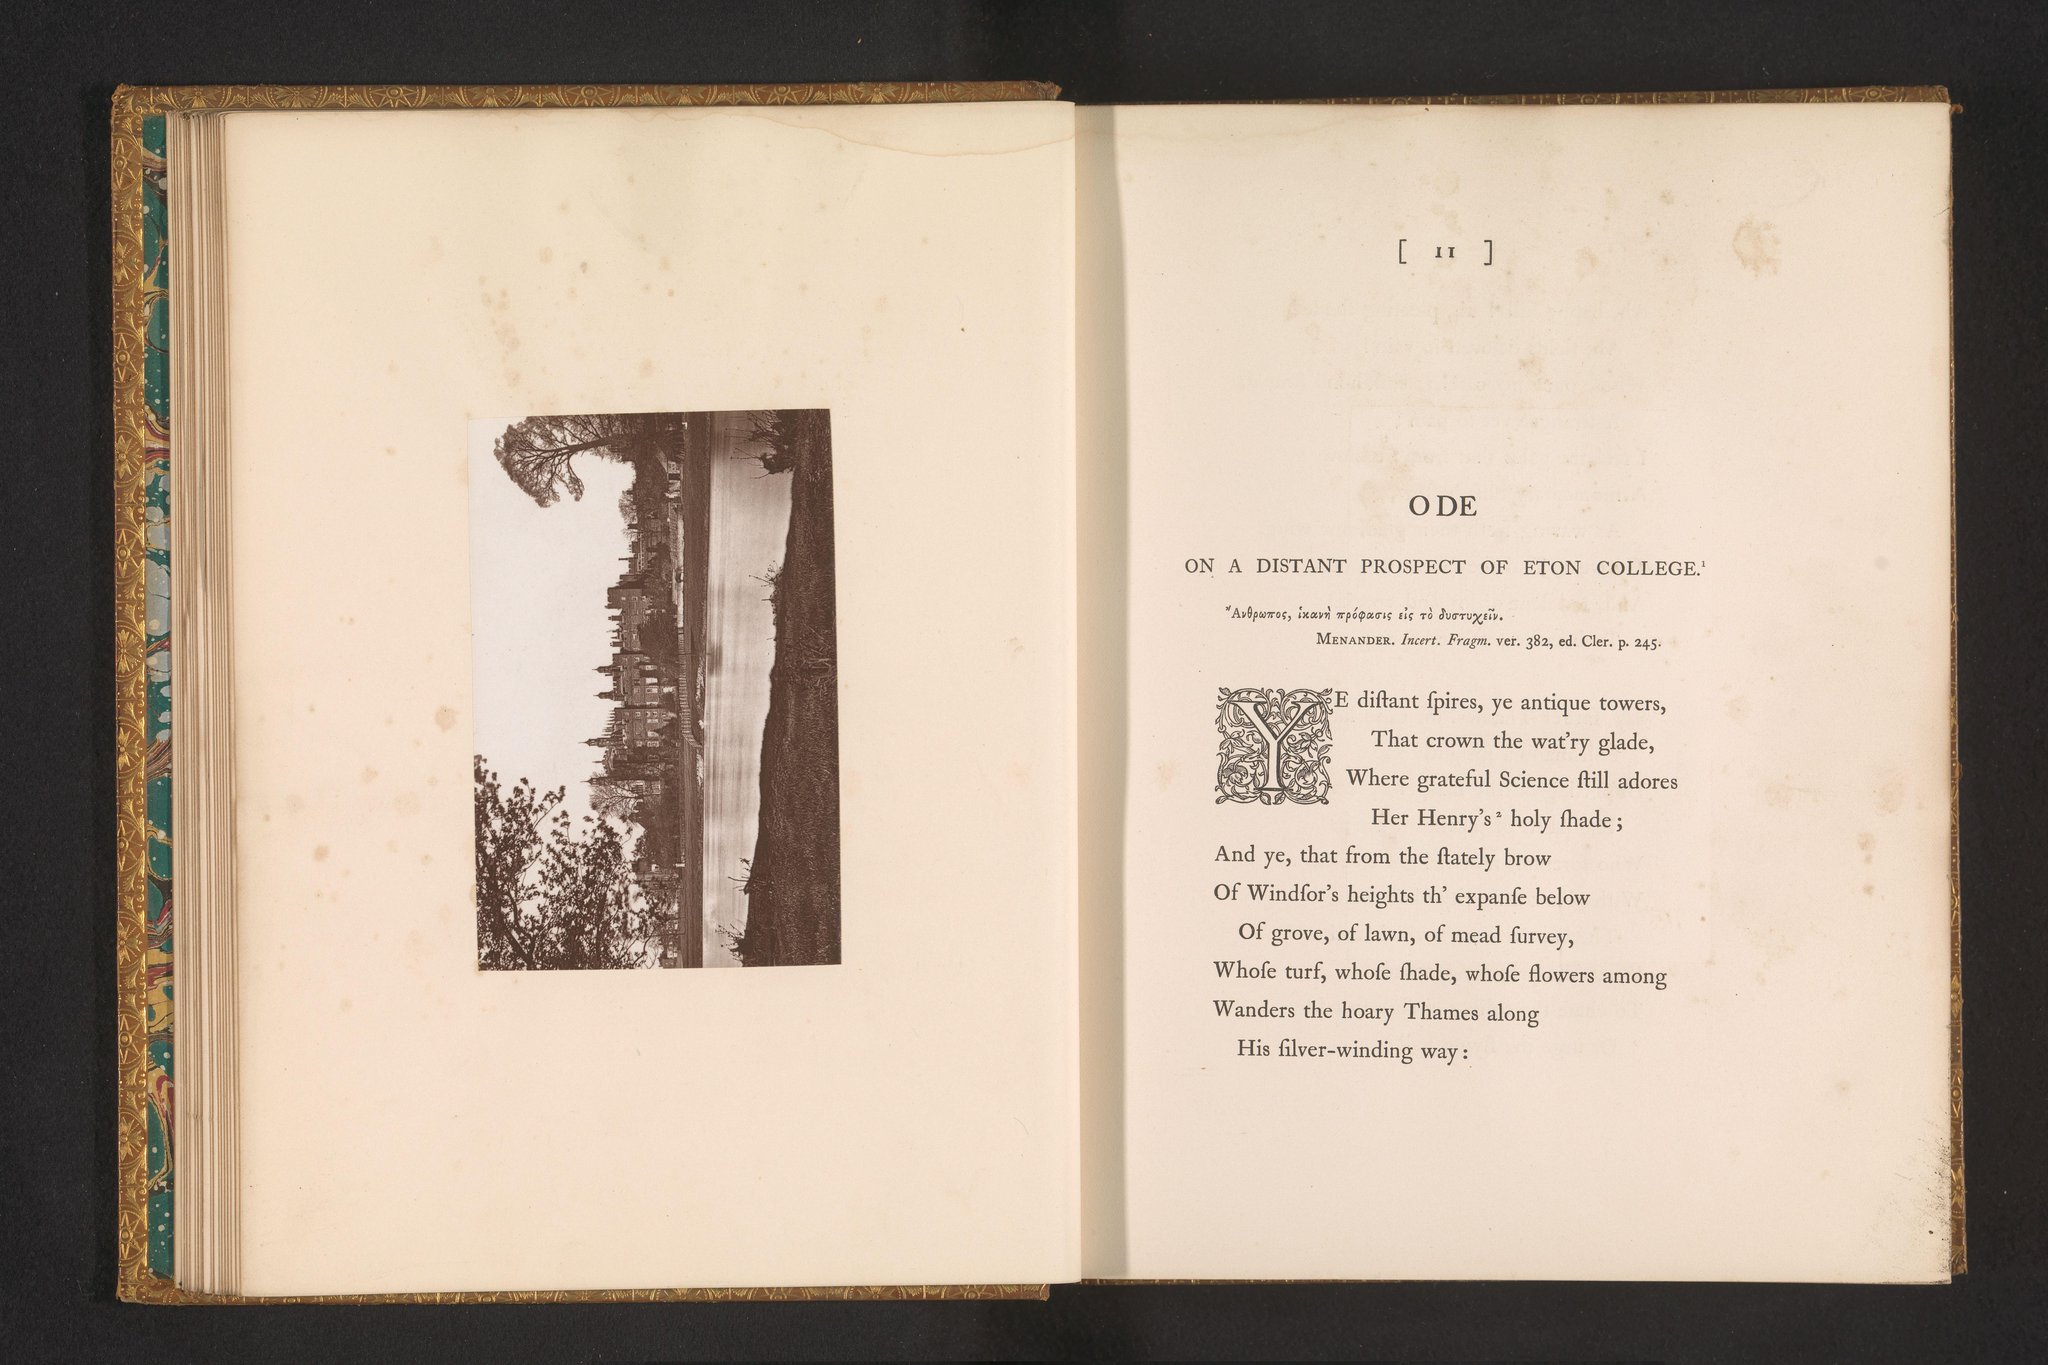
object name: photomechanical print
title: Gezicht op Eton College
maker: Anonymous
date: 1869-1879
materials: paper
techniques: woodburytype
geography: berkshire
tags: university building, college